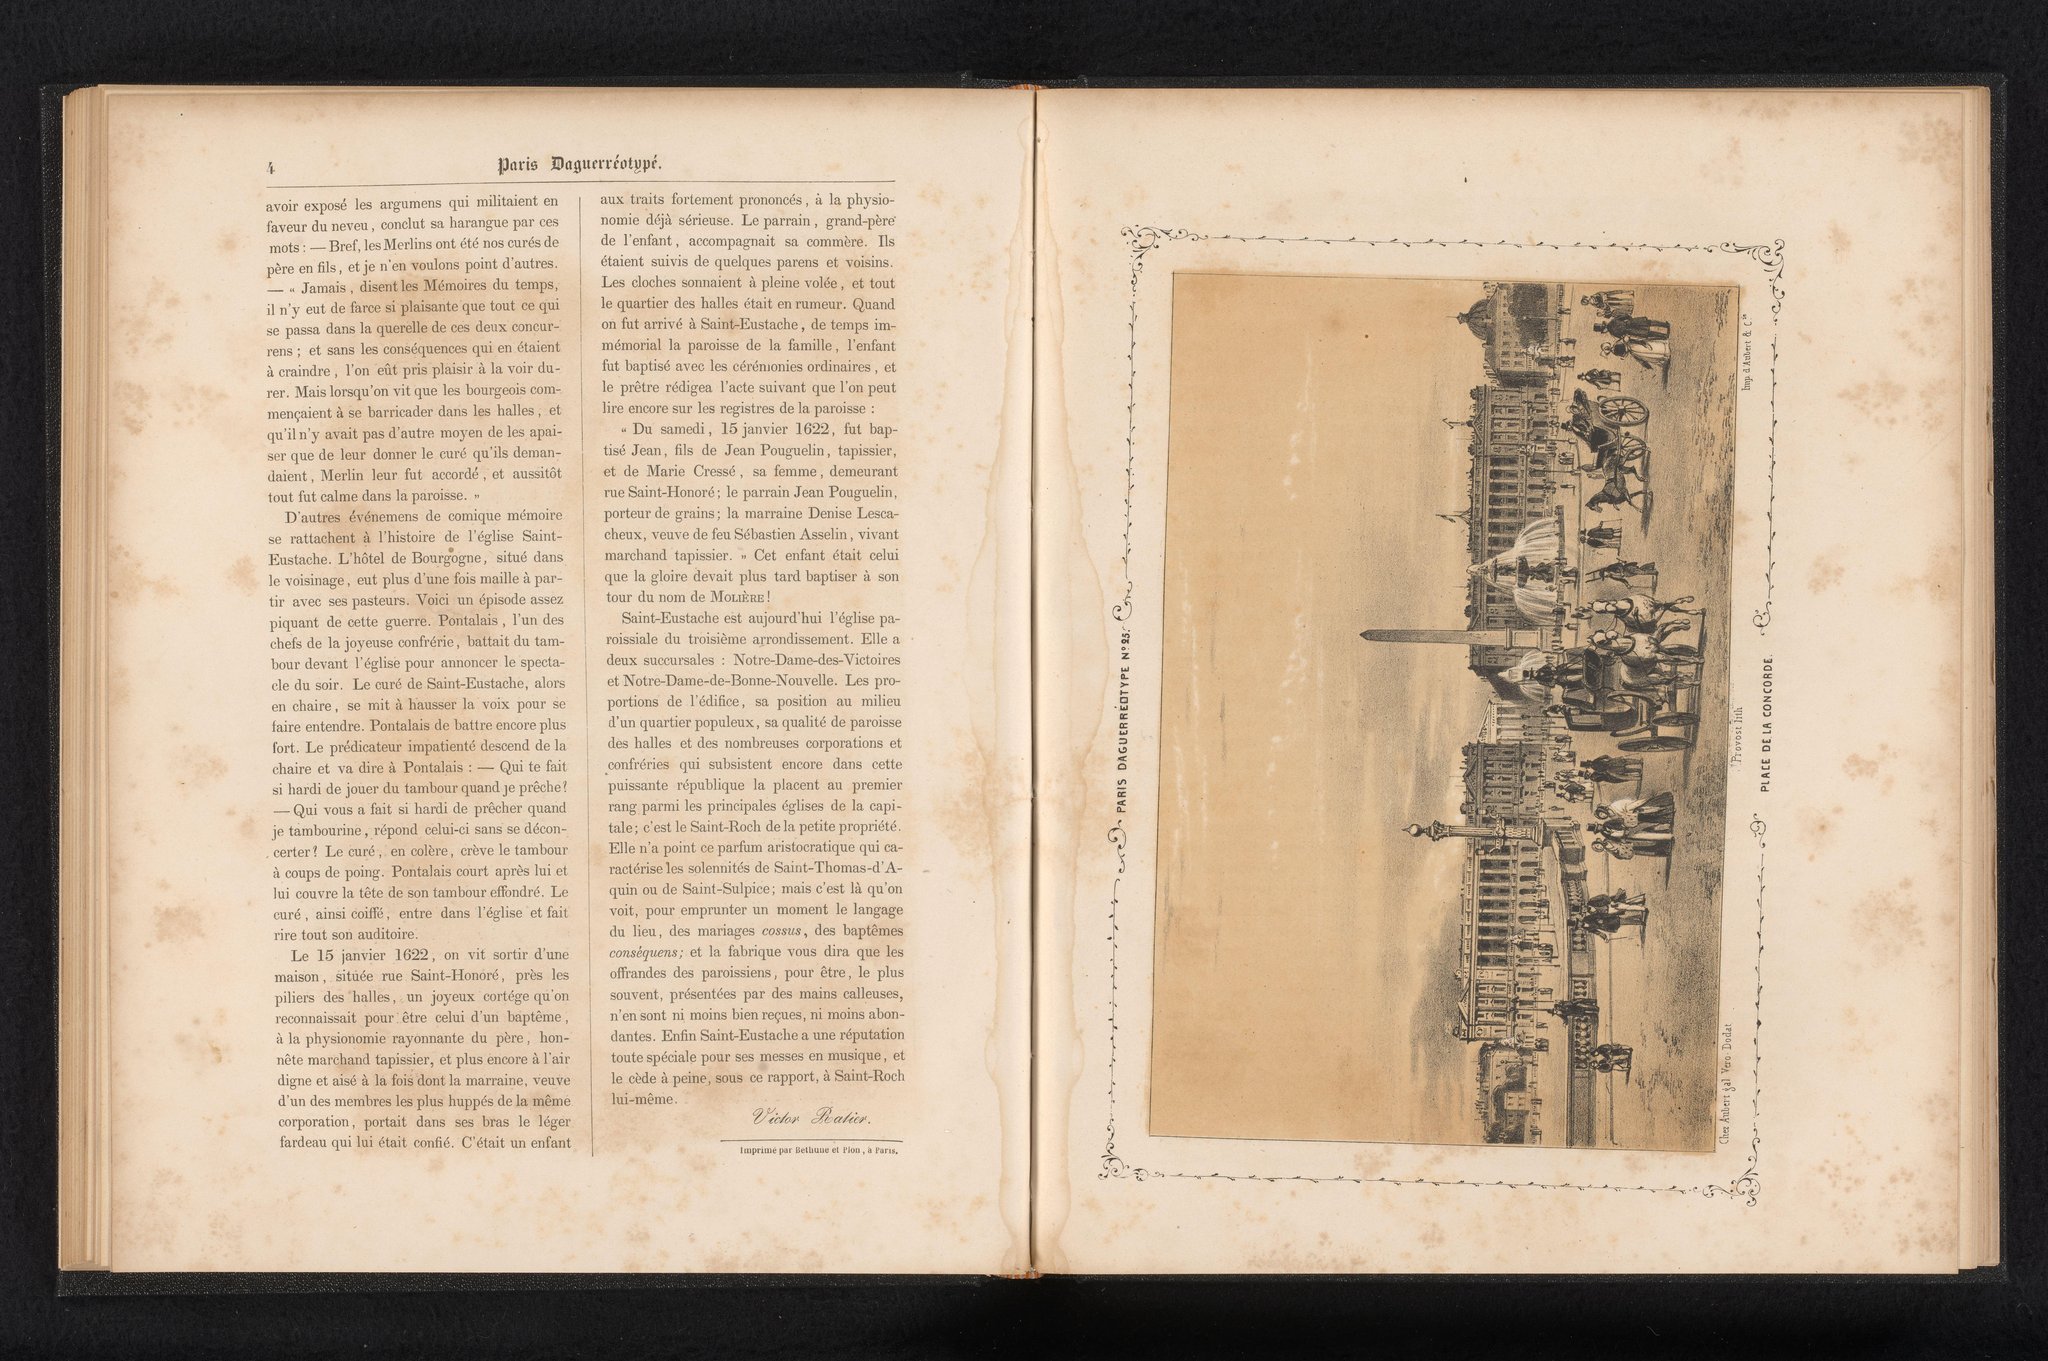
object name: print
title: Place de la Concorde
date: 1839-1840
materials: paper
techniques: tone lithography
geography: paris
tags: square, place, circus, etc.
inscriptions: inscription: ‘PARIS DAGUERRÉOTYPÉ No. 26.’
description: Prent op honderdenderde ongenummerde pagina.